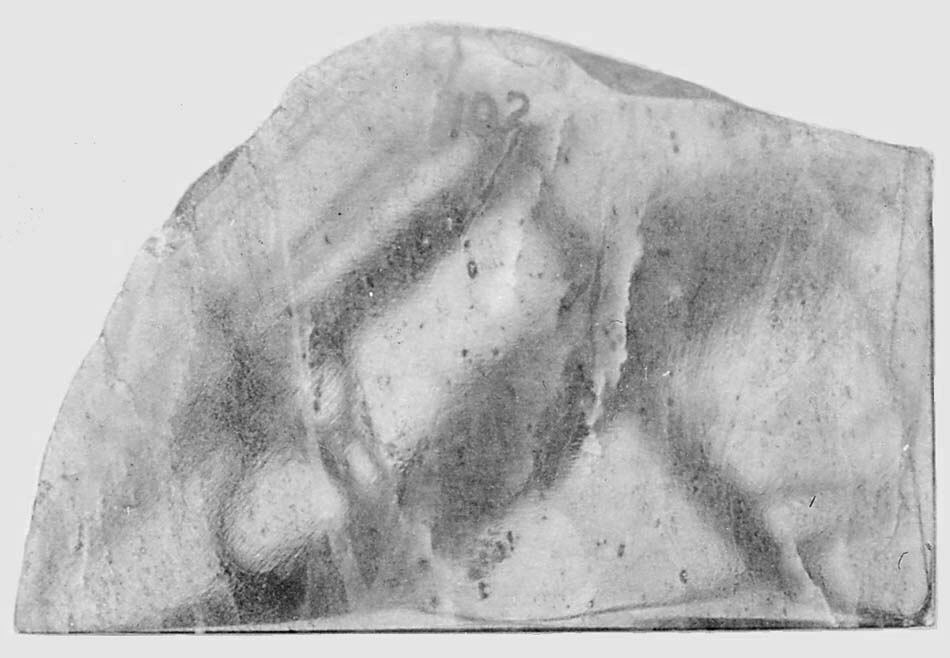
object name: fragment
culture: russian, siberia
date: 1902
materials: jade